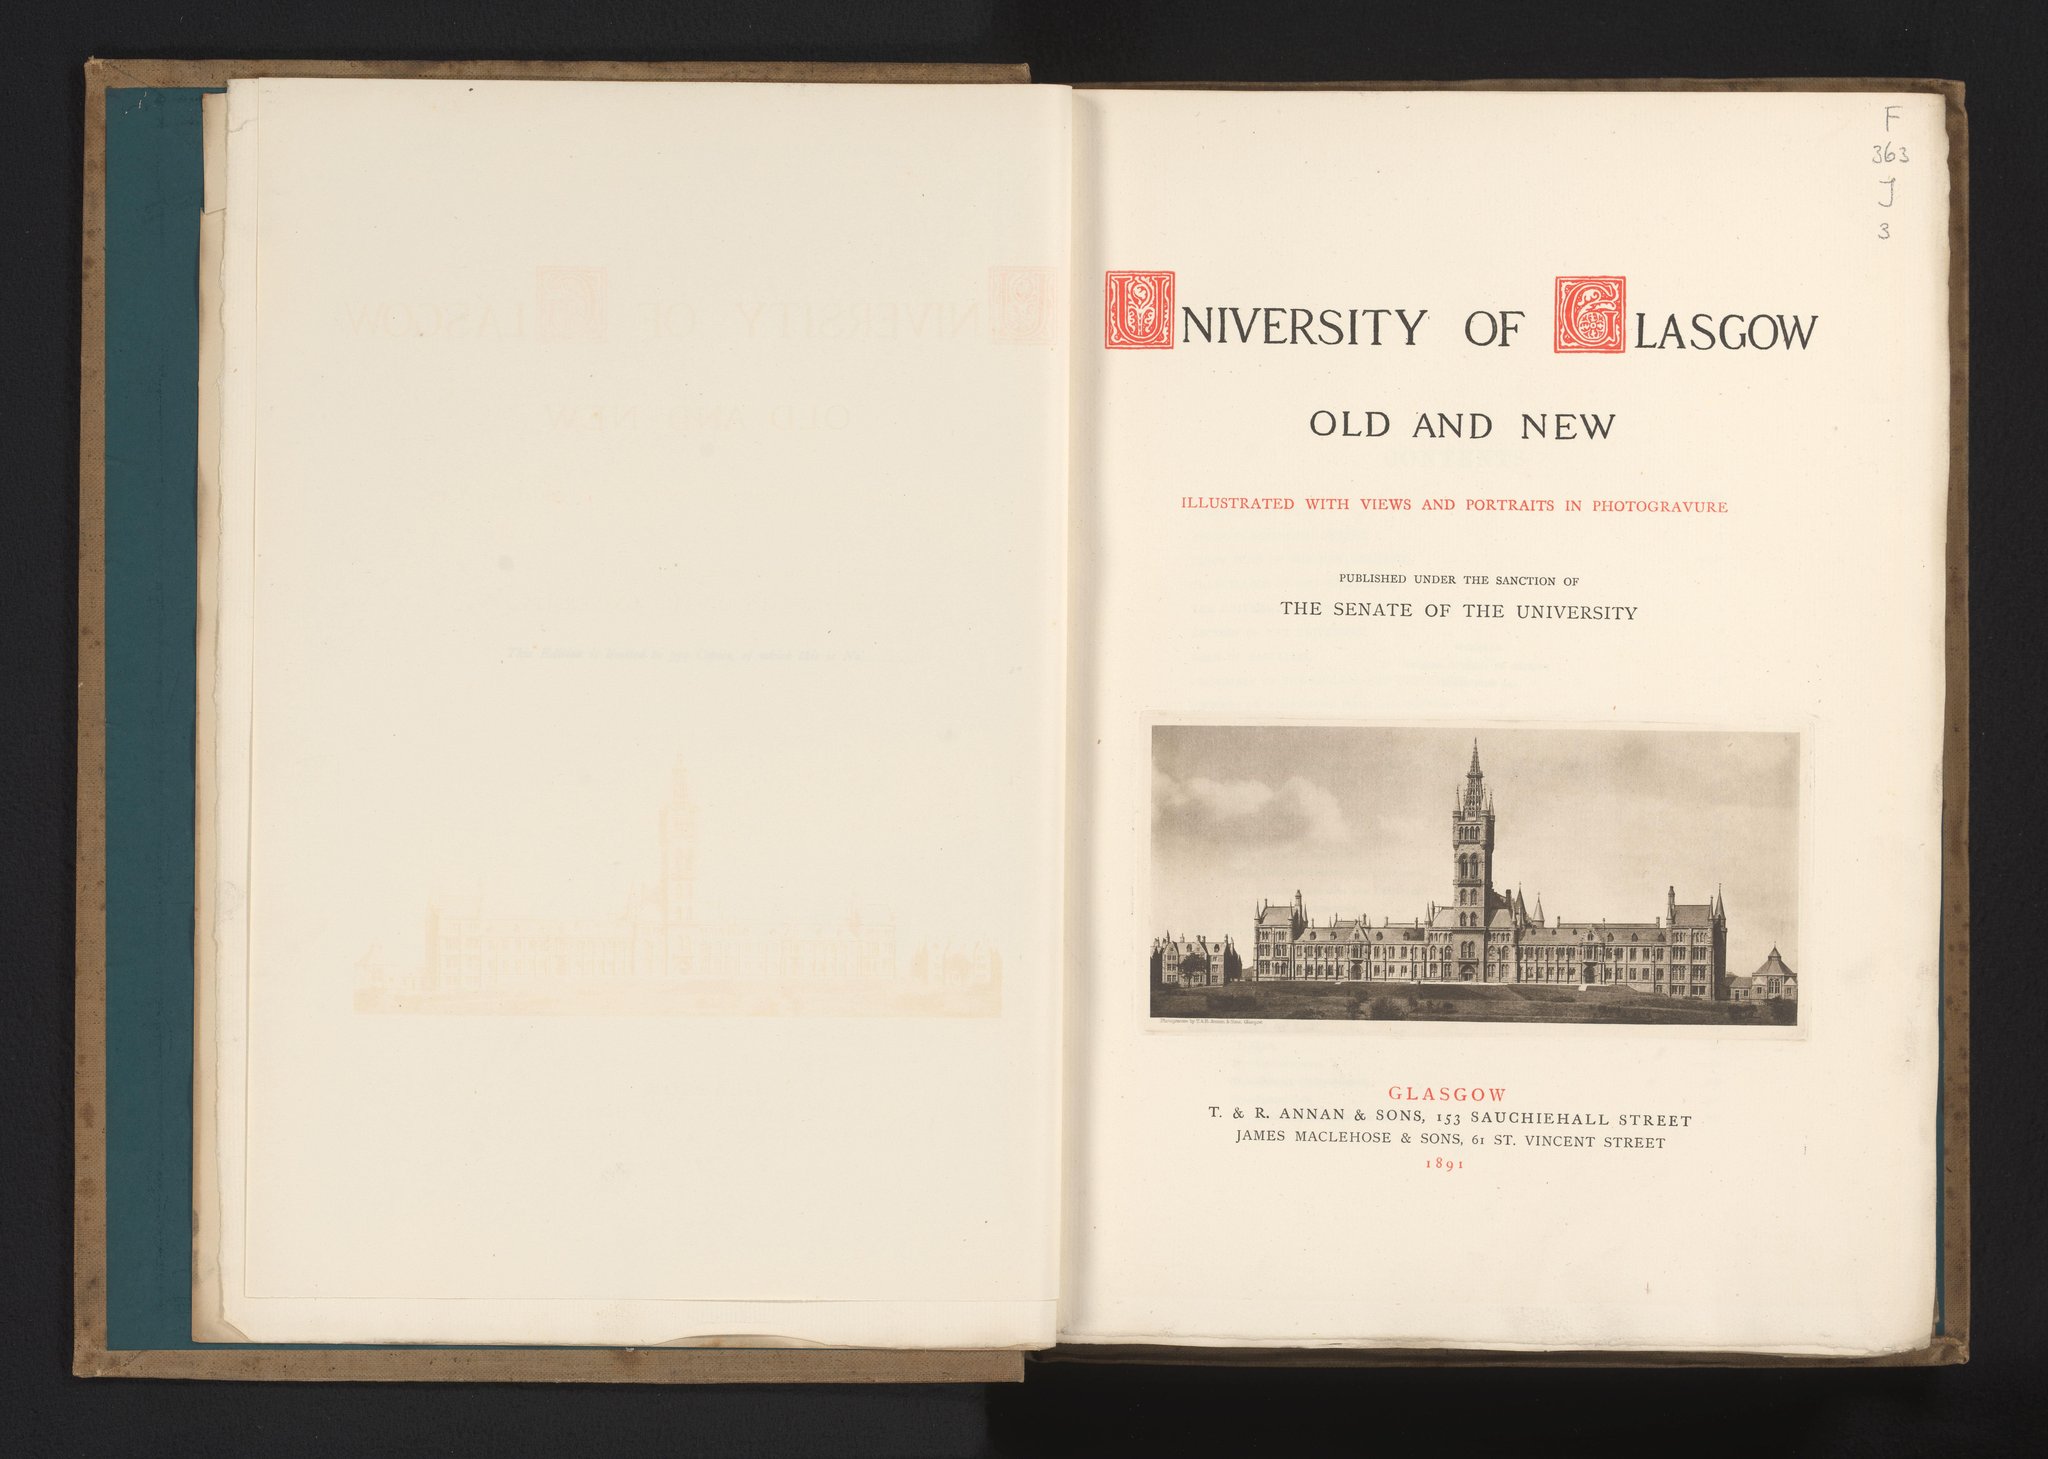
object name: book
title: University of Glasgow : old and new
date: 1891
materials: cardboard, leather, linen, paper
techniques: photoaquatint, printing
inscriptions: date: ‘OCT 1985’, annotation: ‘€70/ ltd 350 copies’